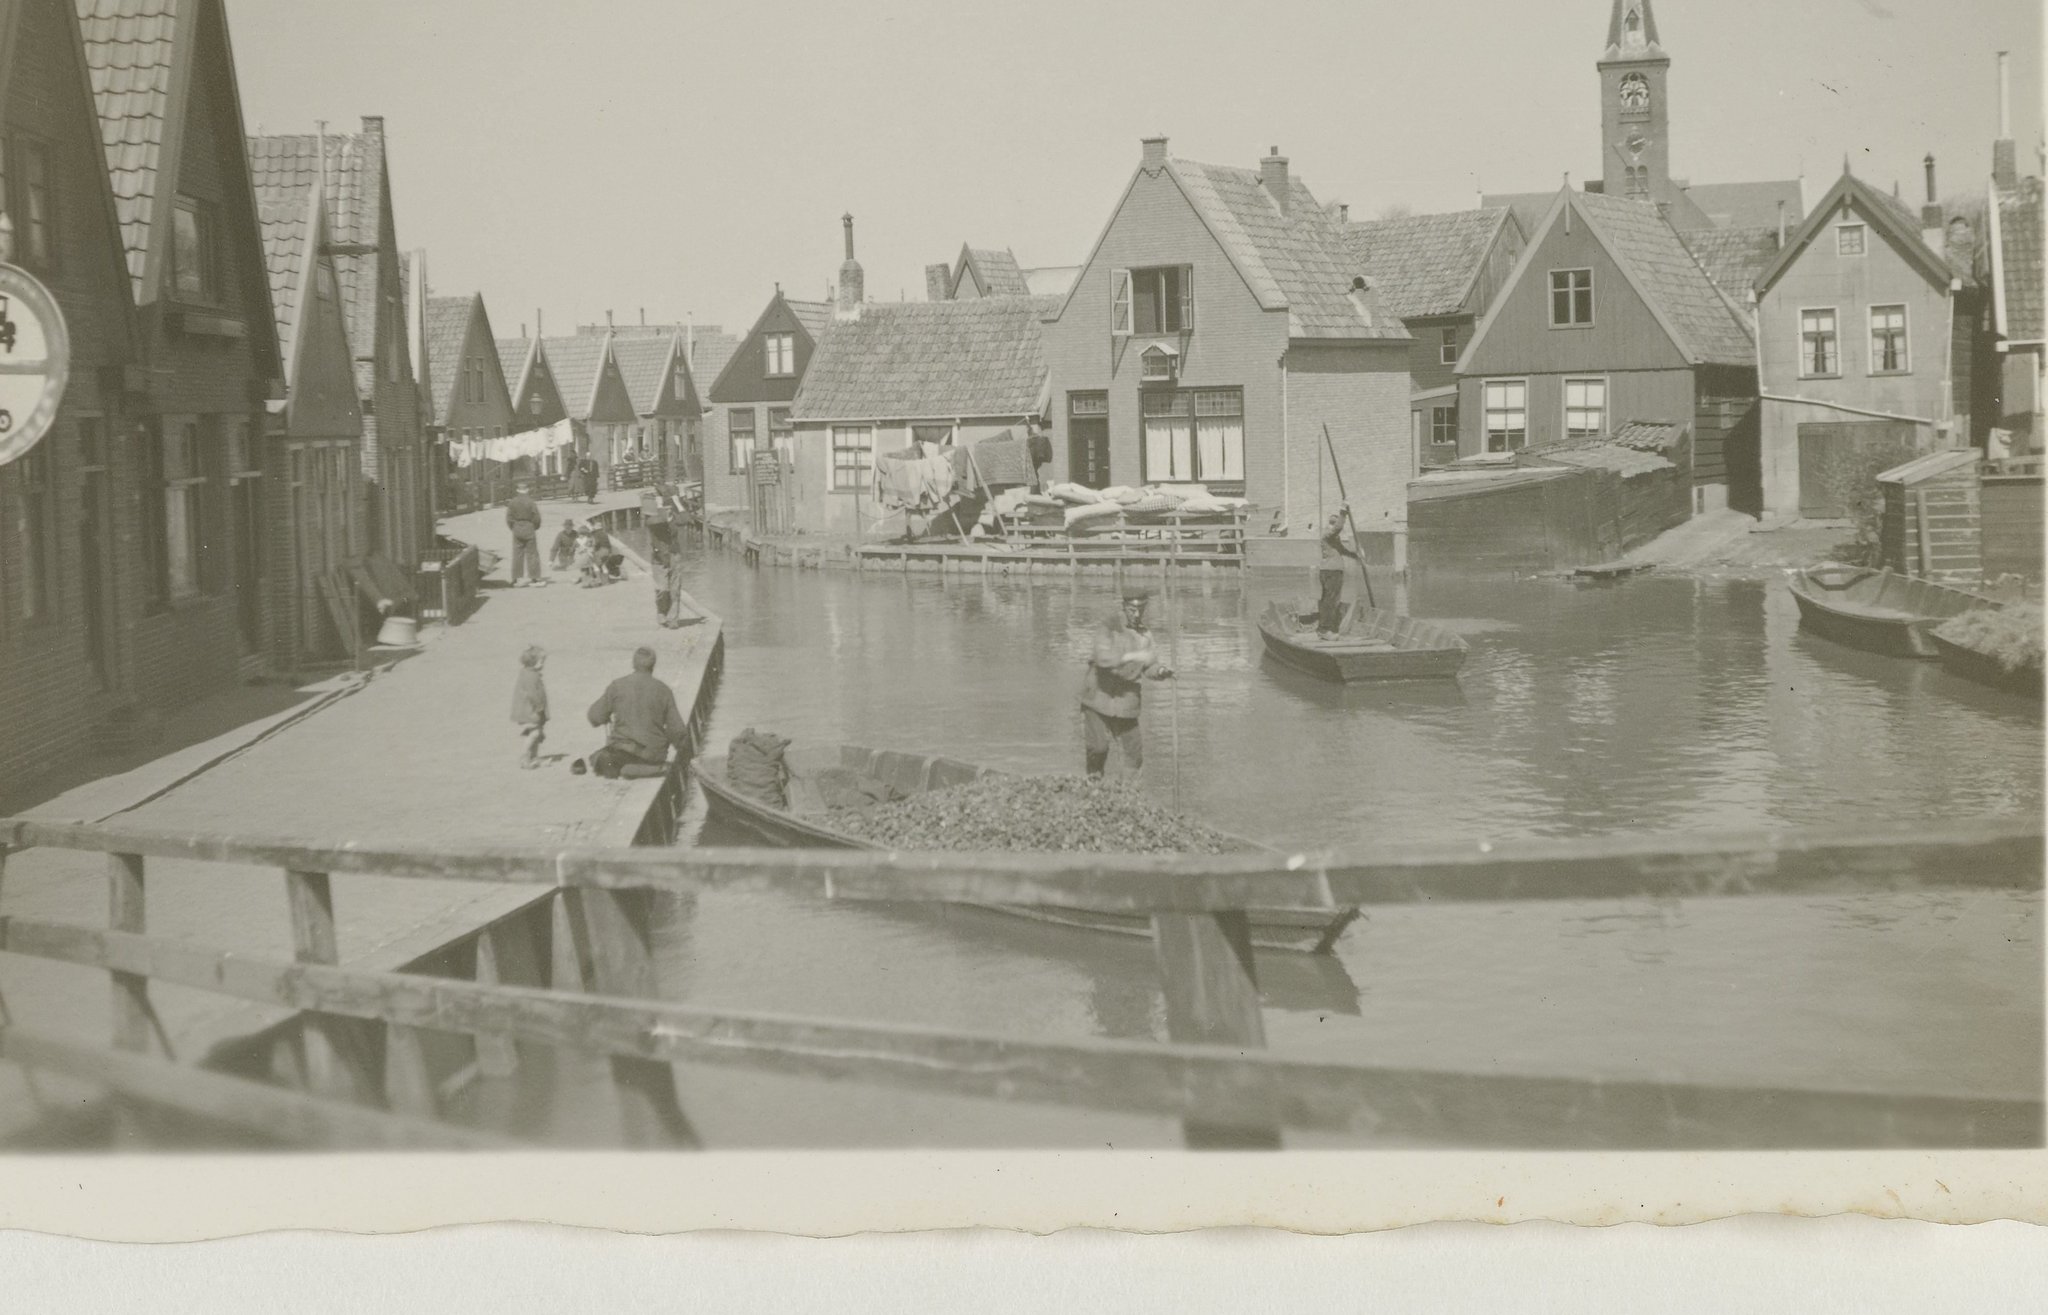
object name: photograph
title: Gezicht op Volendam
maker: Anonymous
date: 1942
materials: photographic support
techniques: gelatin silver print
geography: volendam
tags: occupier and civilians, city-view in general; 'veduta', occupation ~ war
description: Gezicht op Volendam. Links huizen, in het midden een stuk water met boten, een geladen met kolen. Achterop staat: Volendam. 27.4.42.